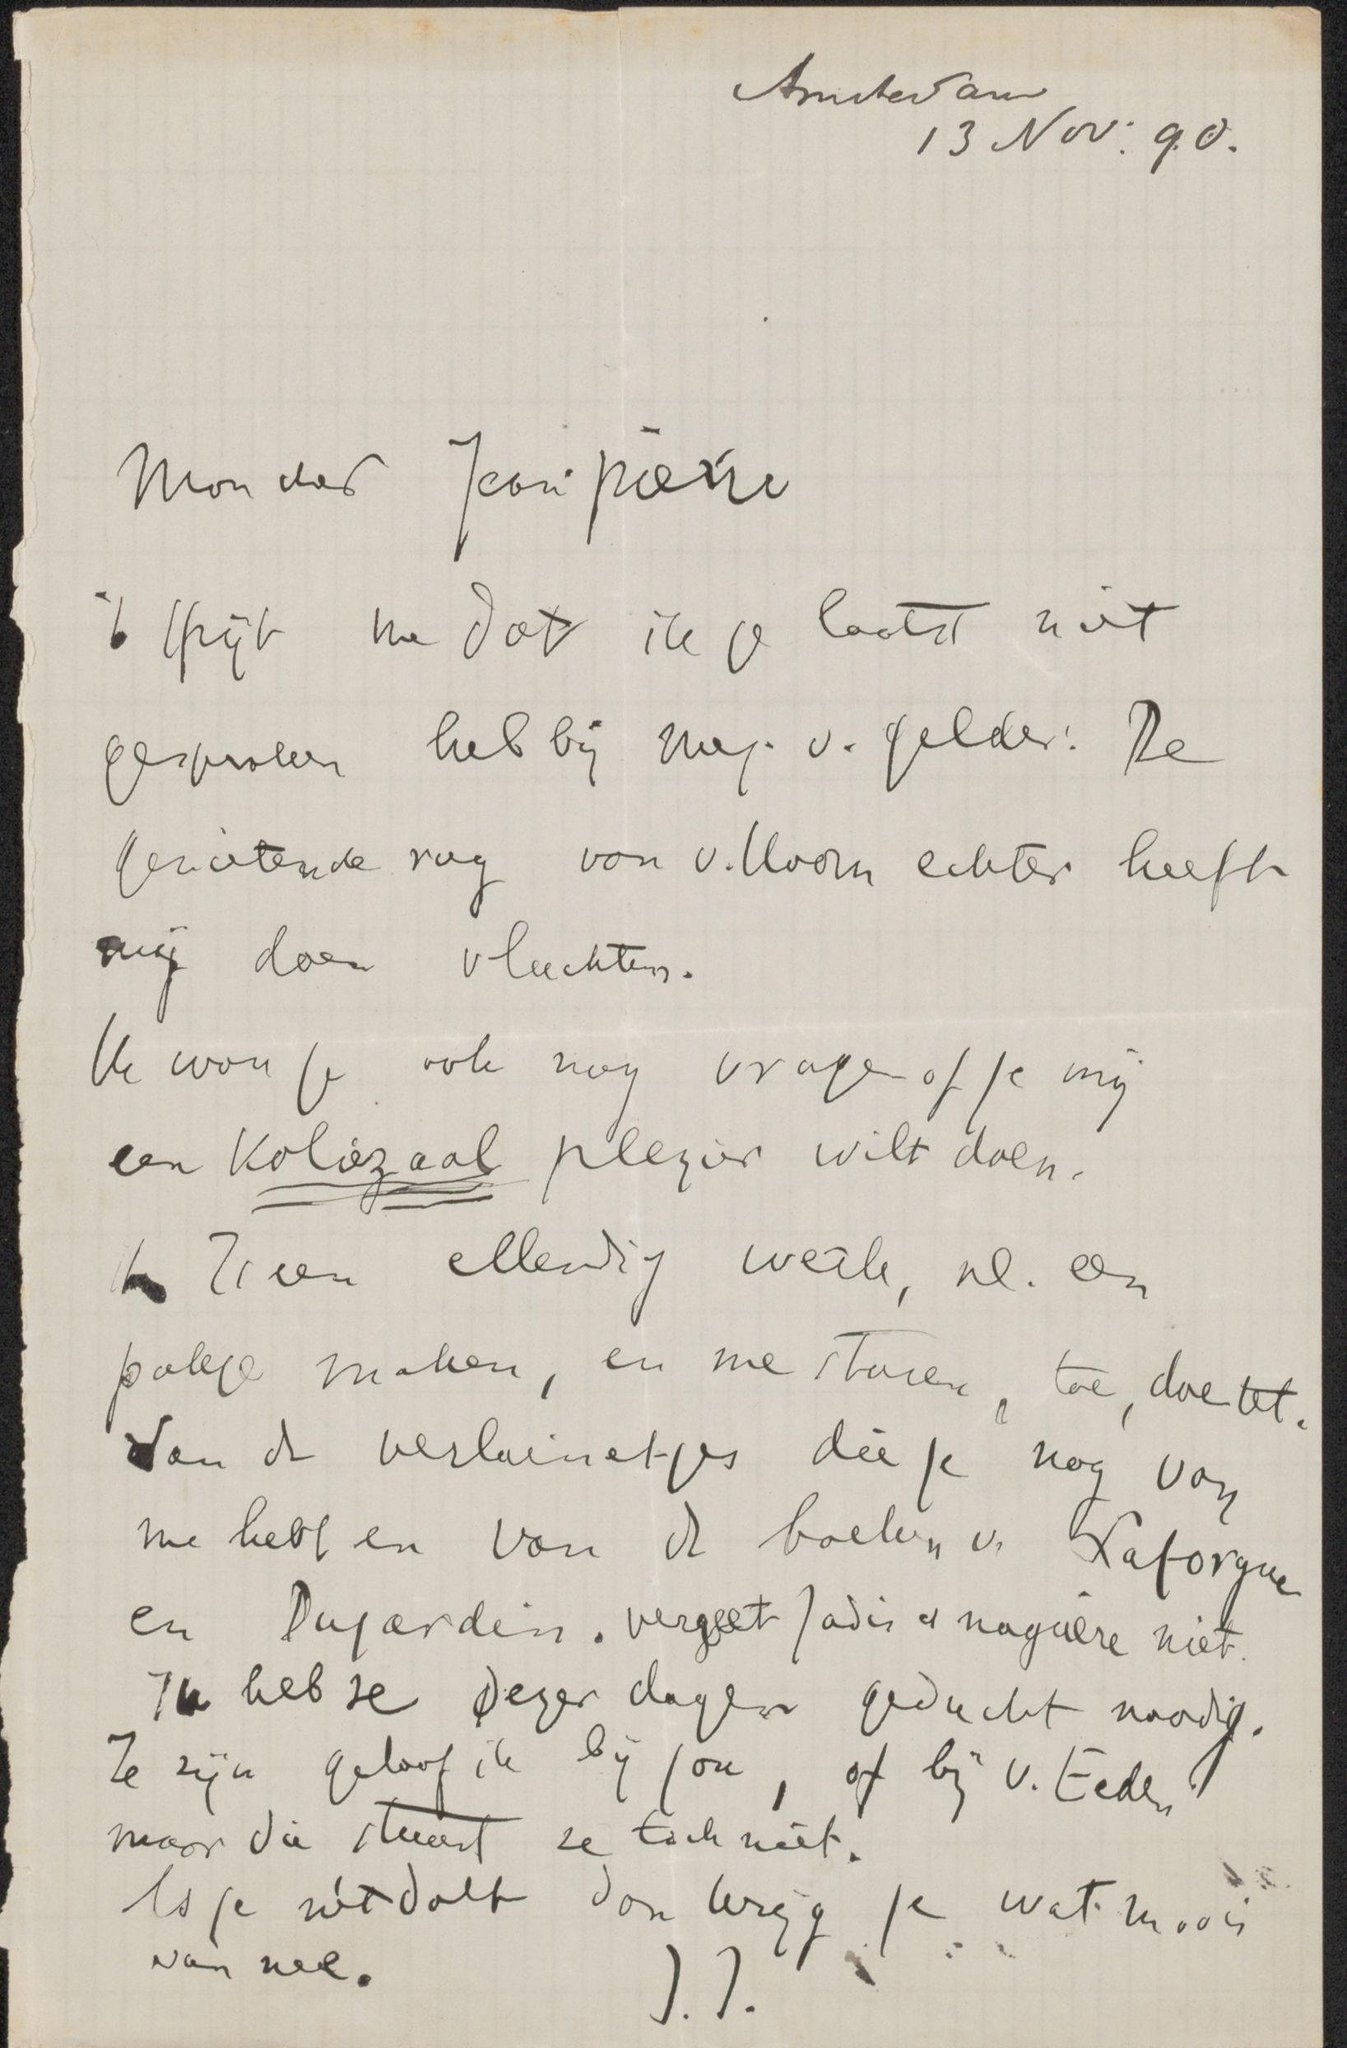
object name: letter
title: Brief aan Jan Veth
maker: isaac israels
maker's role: draughtsman, painter, print maker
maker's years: 1865-1934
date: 1875-1925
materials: ink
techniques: pen, writing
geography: amsterdam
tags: p. laforge, antwerp, edouard dujardin, dordrecht, painter, print maker, draughtsman, designer, jan veth, paris, paul verlaine, haarlem, frederik van eeden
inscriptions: collector's mark: ‘RPK’